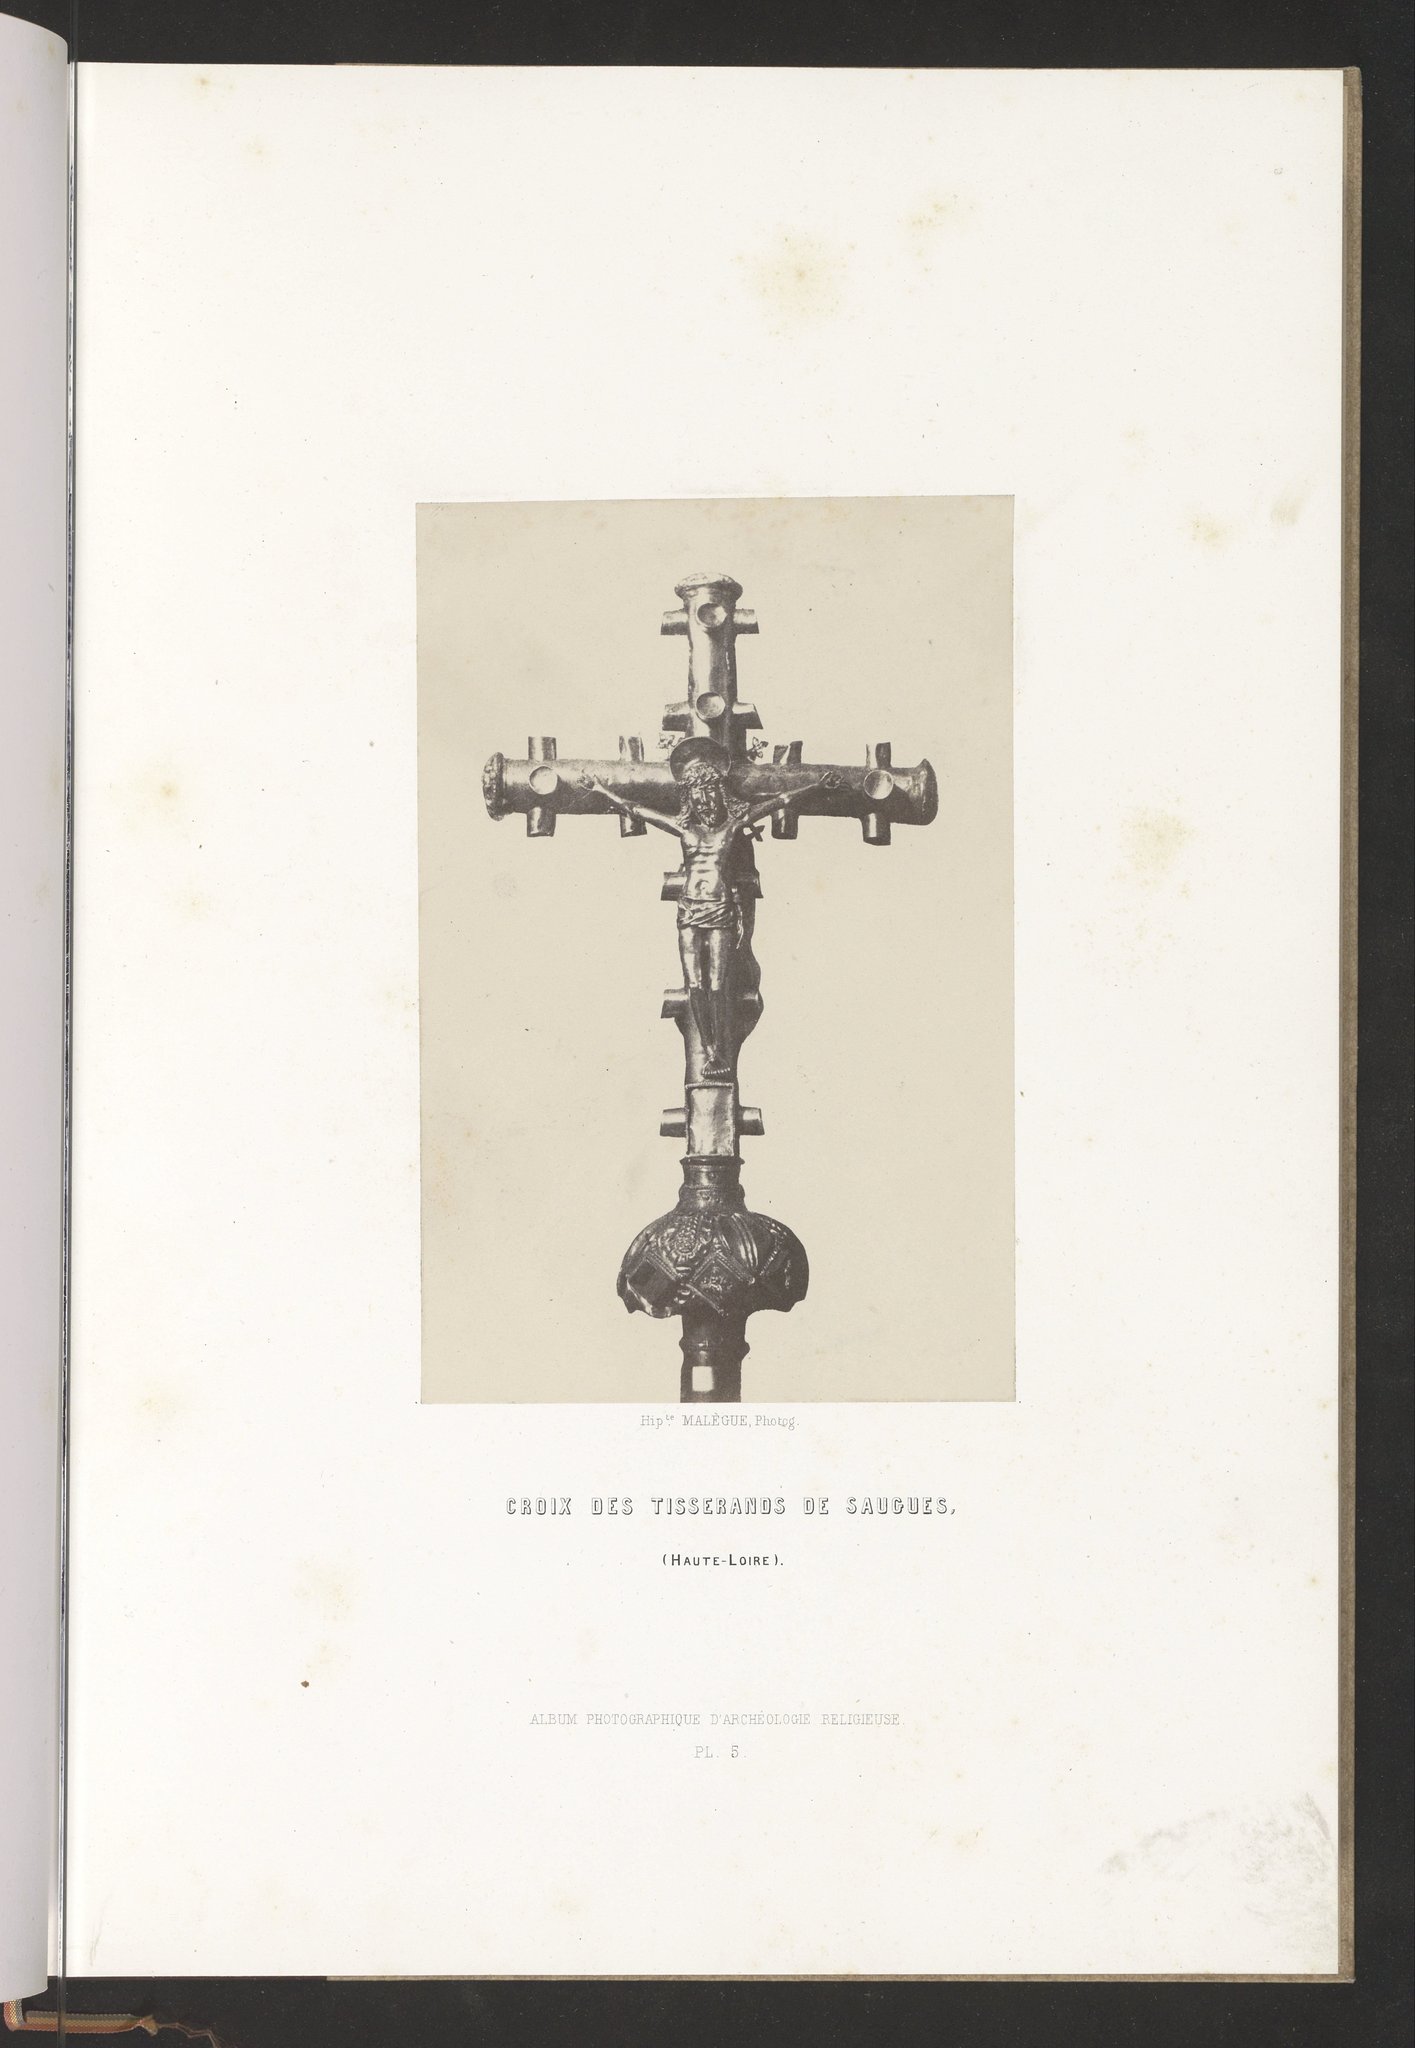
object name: page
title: Kruis van de wevers, afkomstig uit Saugues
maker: hippolyte malègue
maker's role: archeoloog, fotograaf, schrijver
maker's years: 1825-1901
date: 1850-1857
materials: photographic support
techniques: salted paper print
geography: france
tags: crucifix ~ personal devotion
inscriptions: inscription: ‘(Haute-Loire).’, number: ‘PL. 5.’